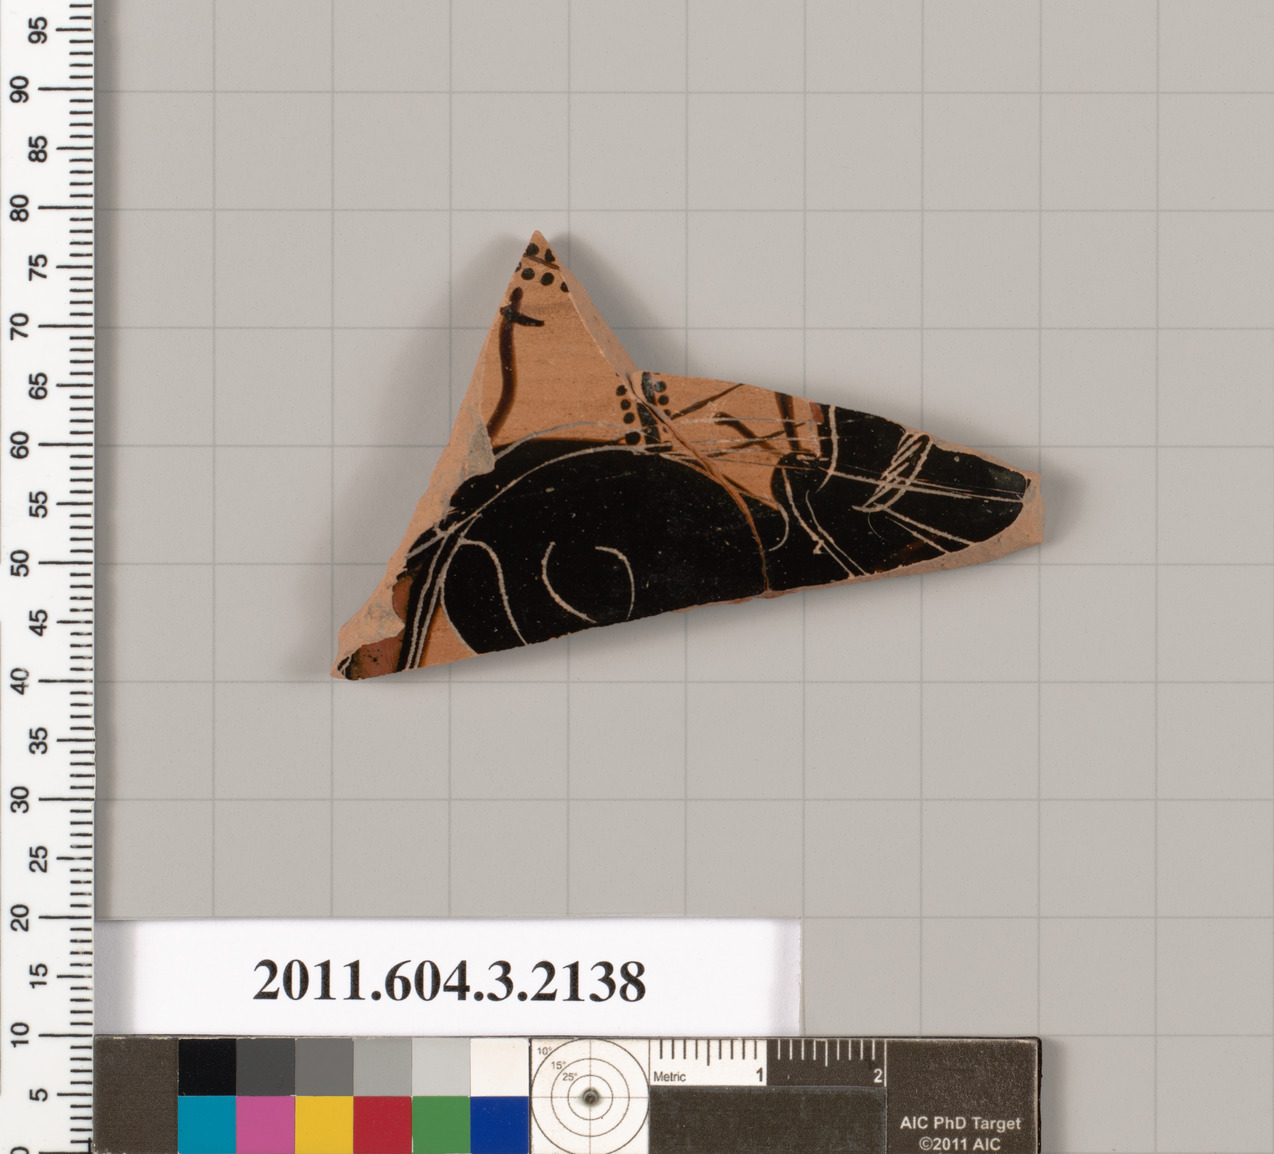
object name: kylix fragment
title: Terracotta fragment of a kylix (drinking cup)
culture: greek, attic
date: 525-501 BCE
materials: terracotta